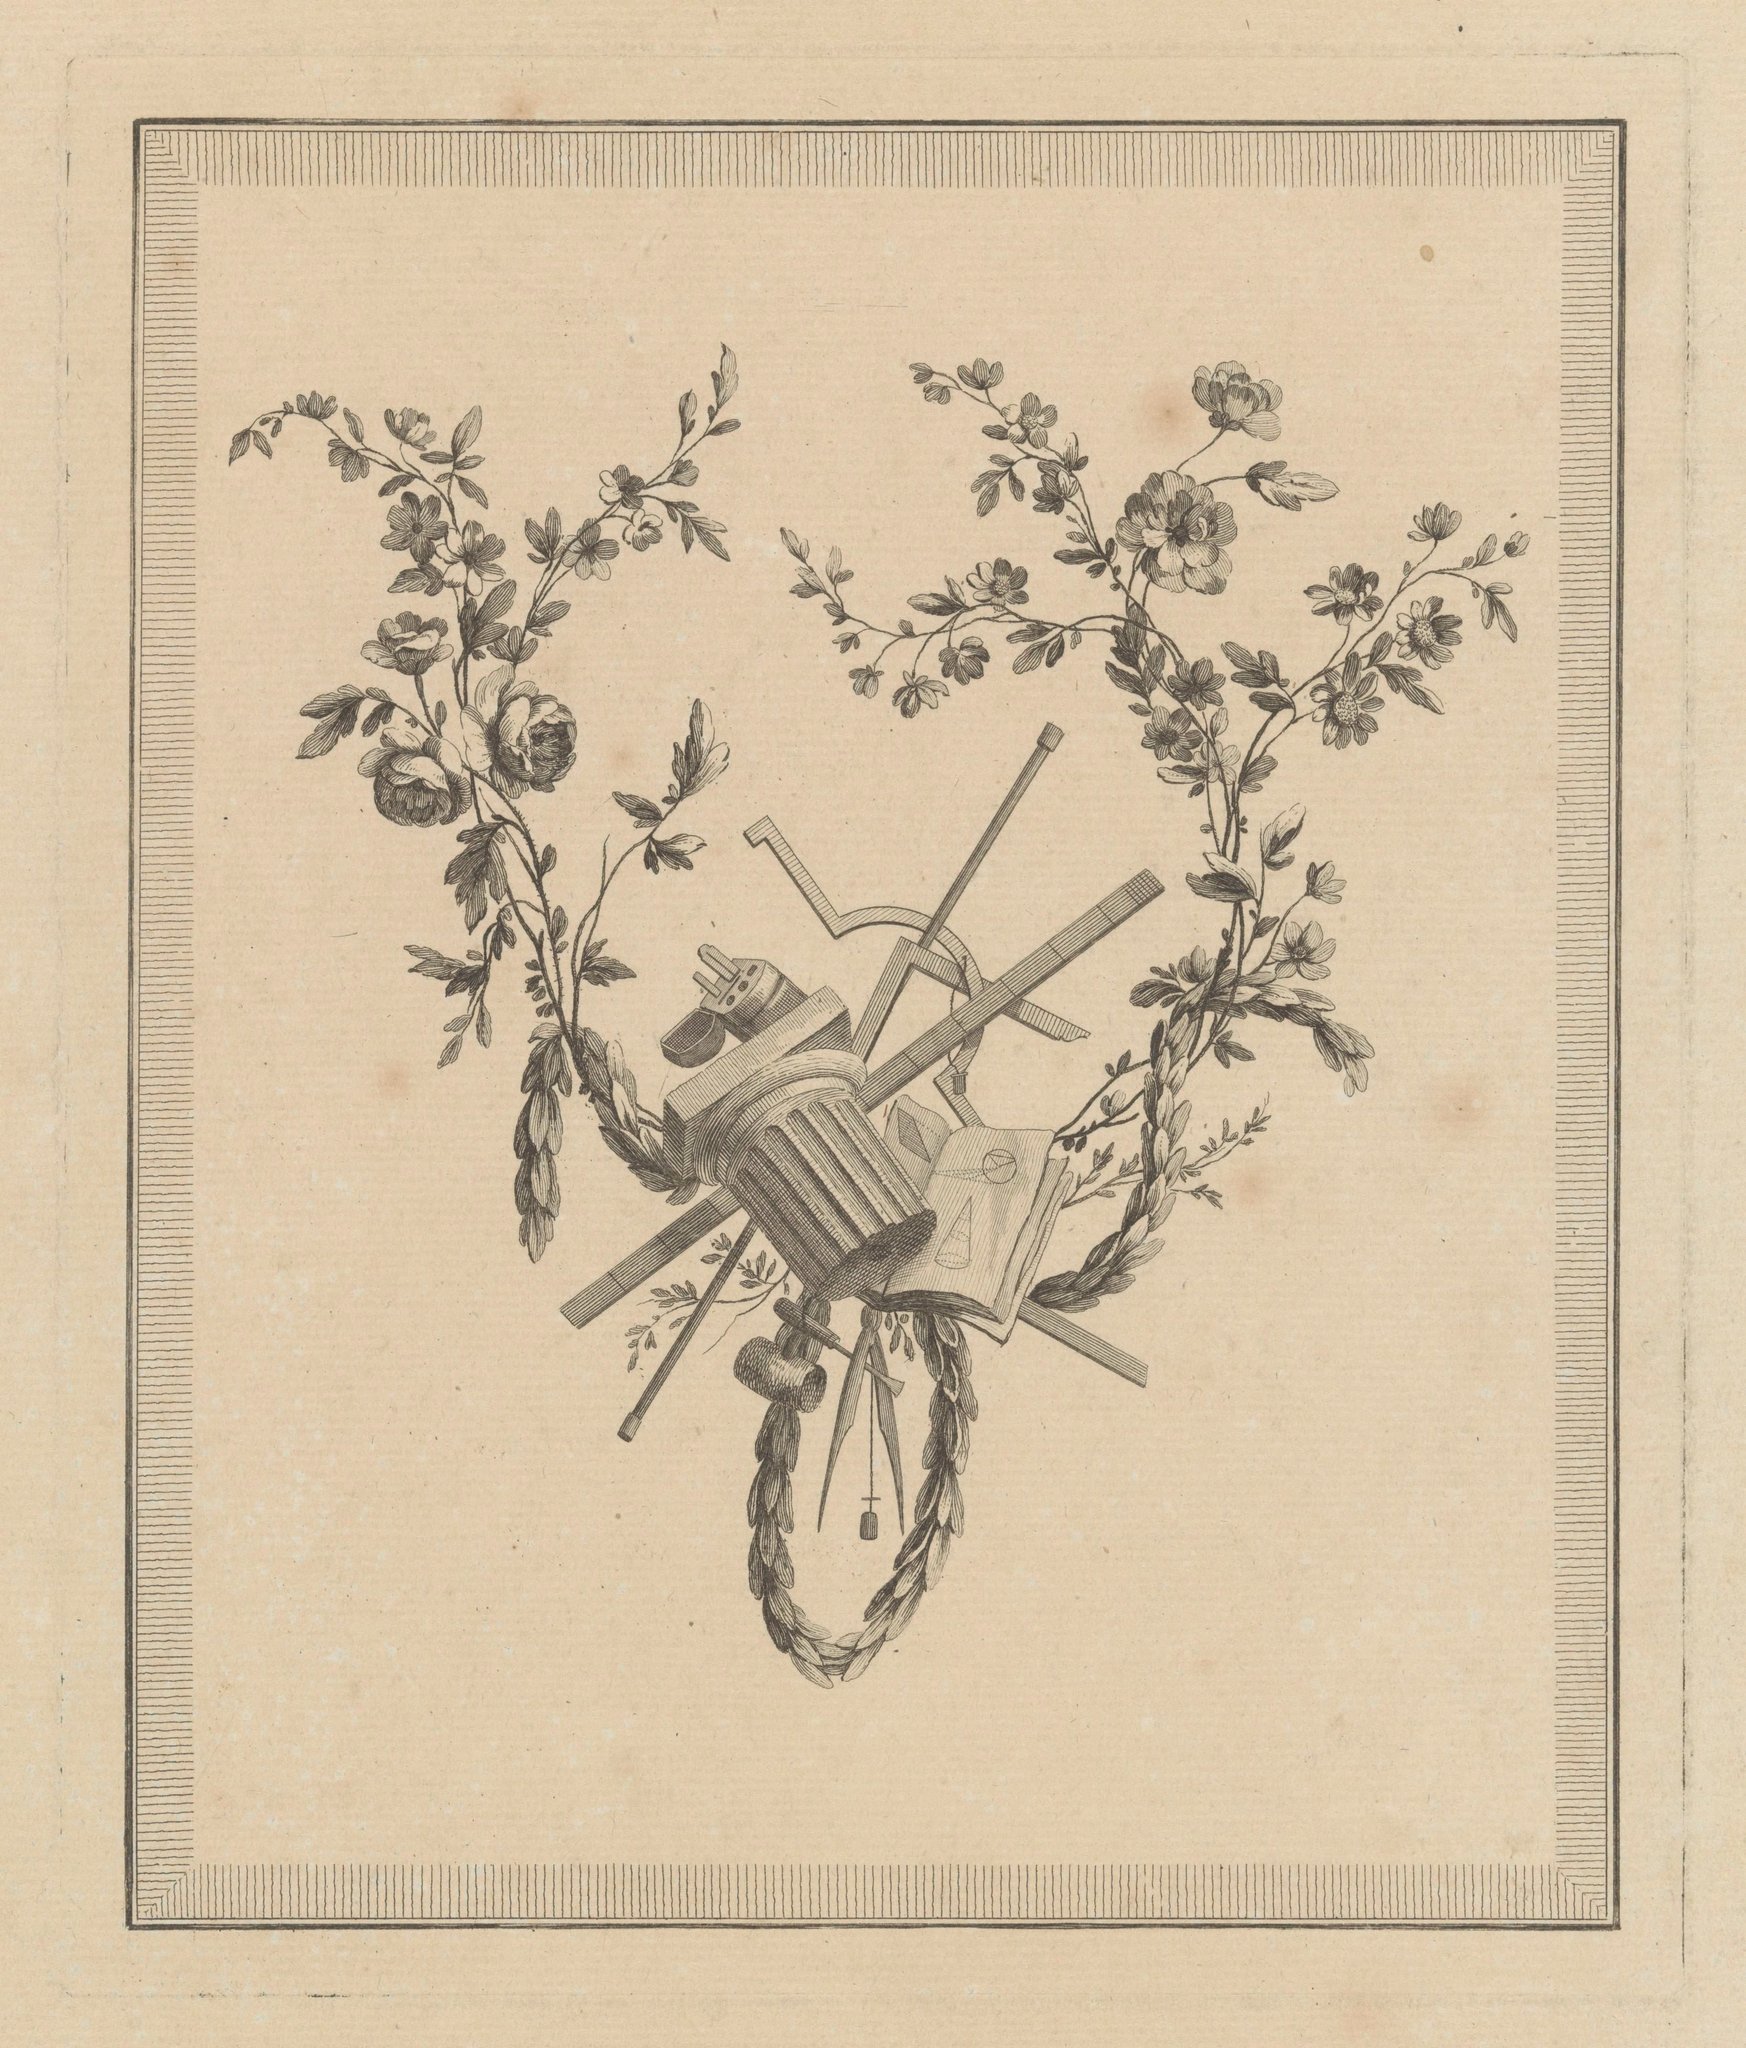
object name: print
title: Architectuur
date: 1760-1784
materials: paper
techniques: etching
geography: paris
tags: trophy, i.e.: decorative arrangement of symbolic or typical objects ~ ornament, 'architectura', symbolic representations, allegories and emblems ~ architecture; 'architettura' (ripa)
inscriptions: collector's mark: Lugt 2228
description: Een trofee met bloemen en attributen behorende bij architectuur zoals een basement van een zuil, een boek met tekeningen en meetinstrumenten.